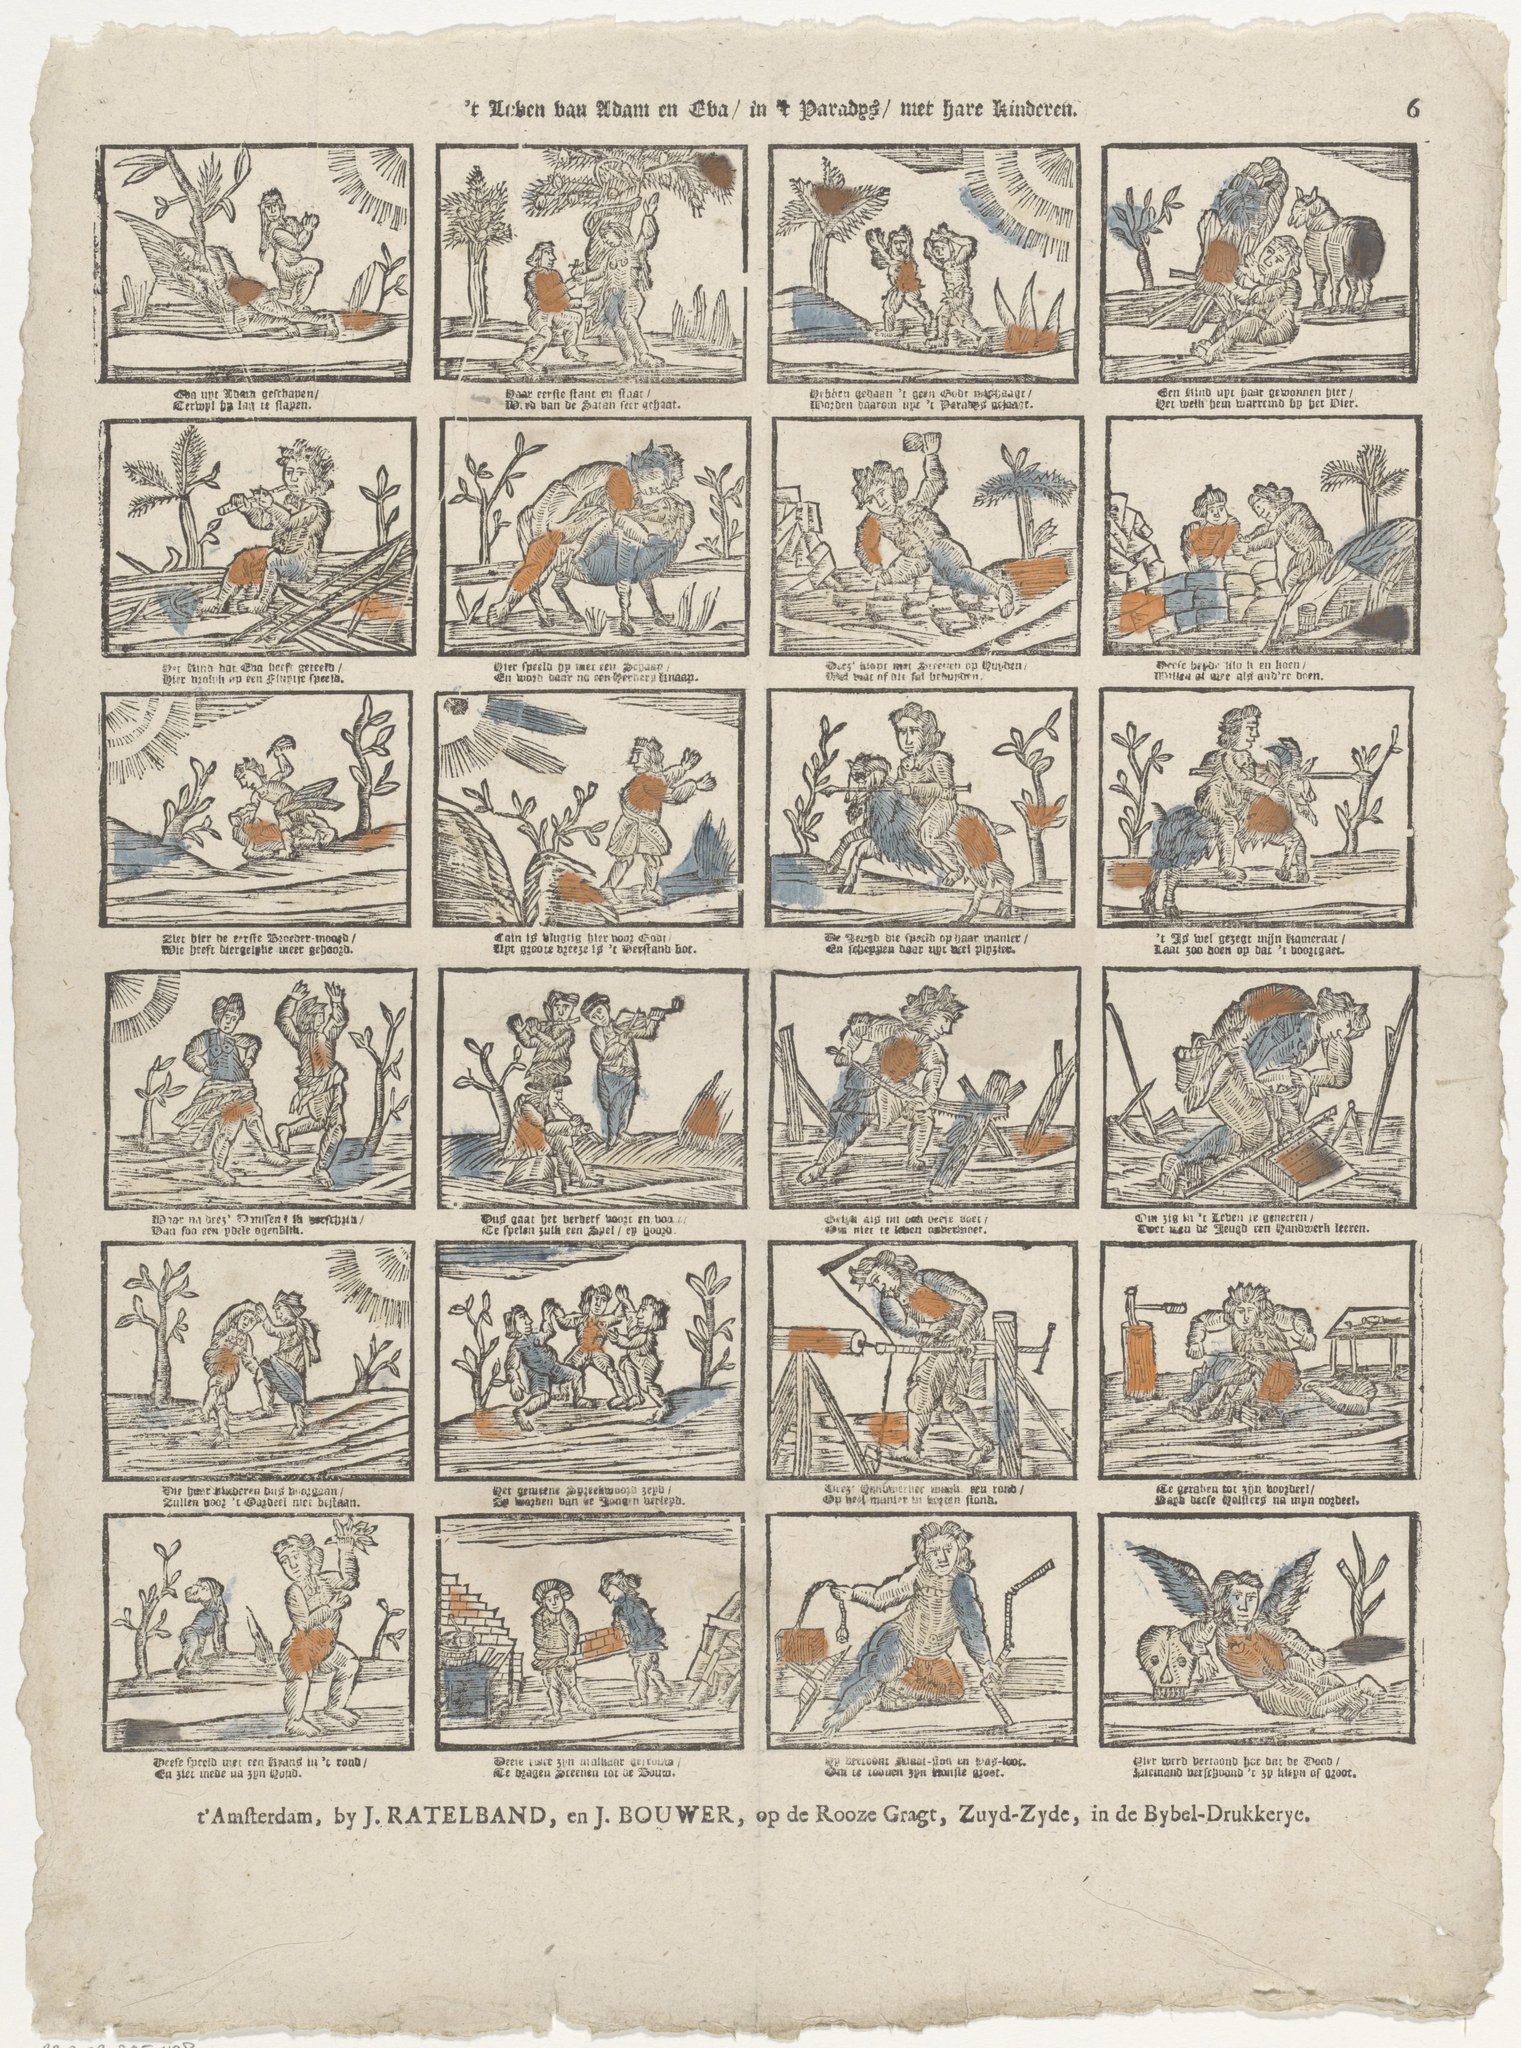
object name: print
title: 't Leven van Adam en Eva / in 't paradys / met hare kinderen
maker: Anonymous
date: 1760-1767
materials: paper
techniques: colour, letterpress printing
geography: amsterdam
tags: craft-production, skilled handiwork, expulsion of adam and eve from paradise (genesis 3:22-24), old testament, crafts and industries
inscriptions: collector's mark: Lugt 2760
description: Blad met 24 voorstellingen van verhalen uit het Oude Testament en voorstellingen van ambachten en bezigheden. Onder elke afbeelding een tweeregelig vers. Genummerd rechtsboven: 6.